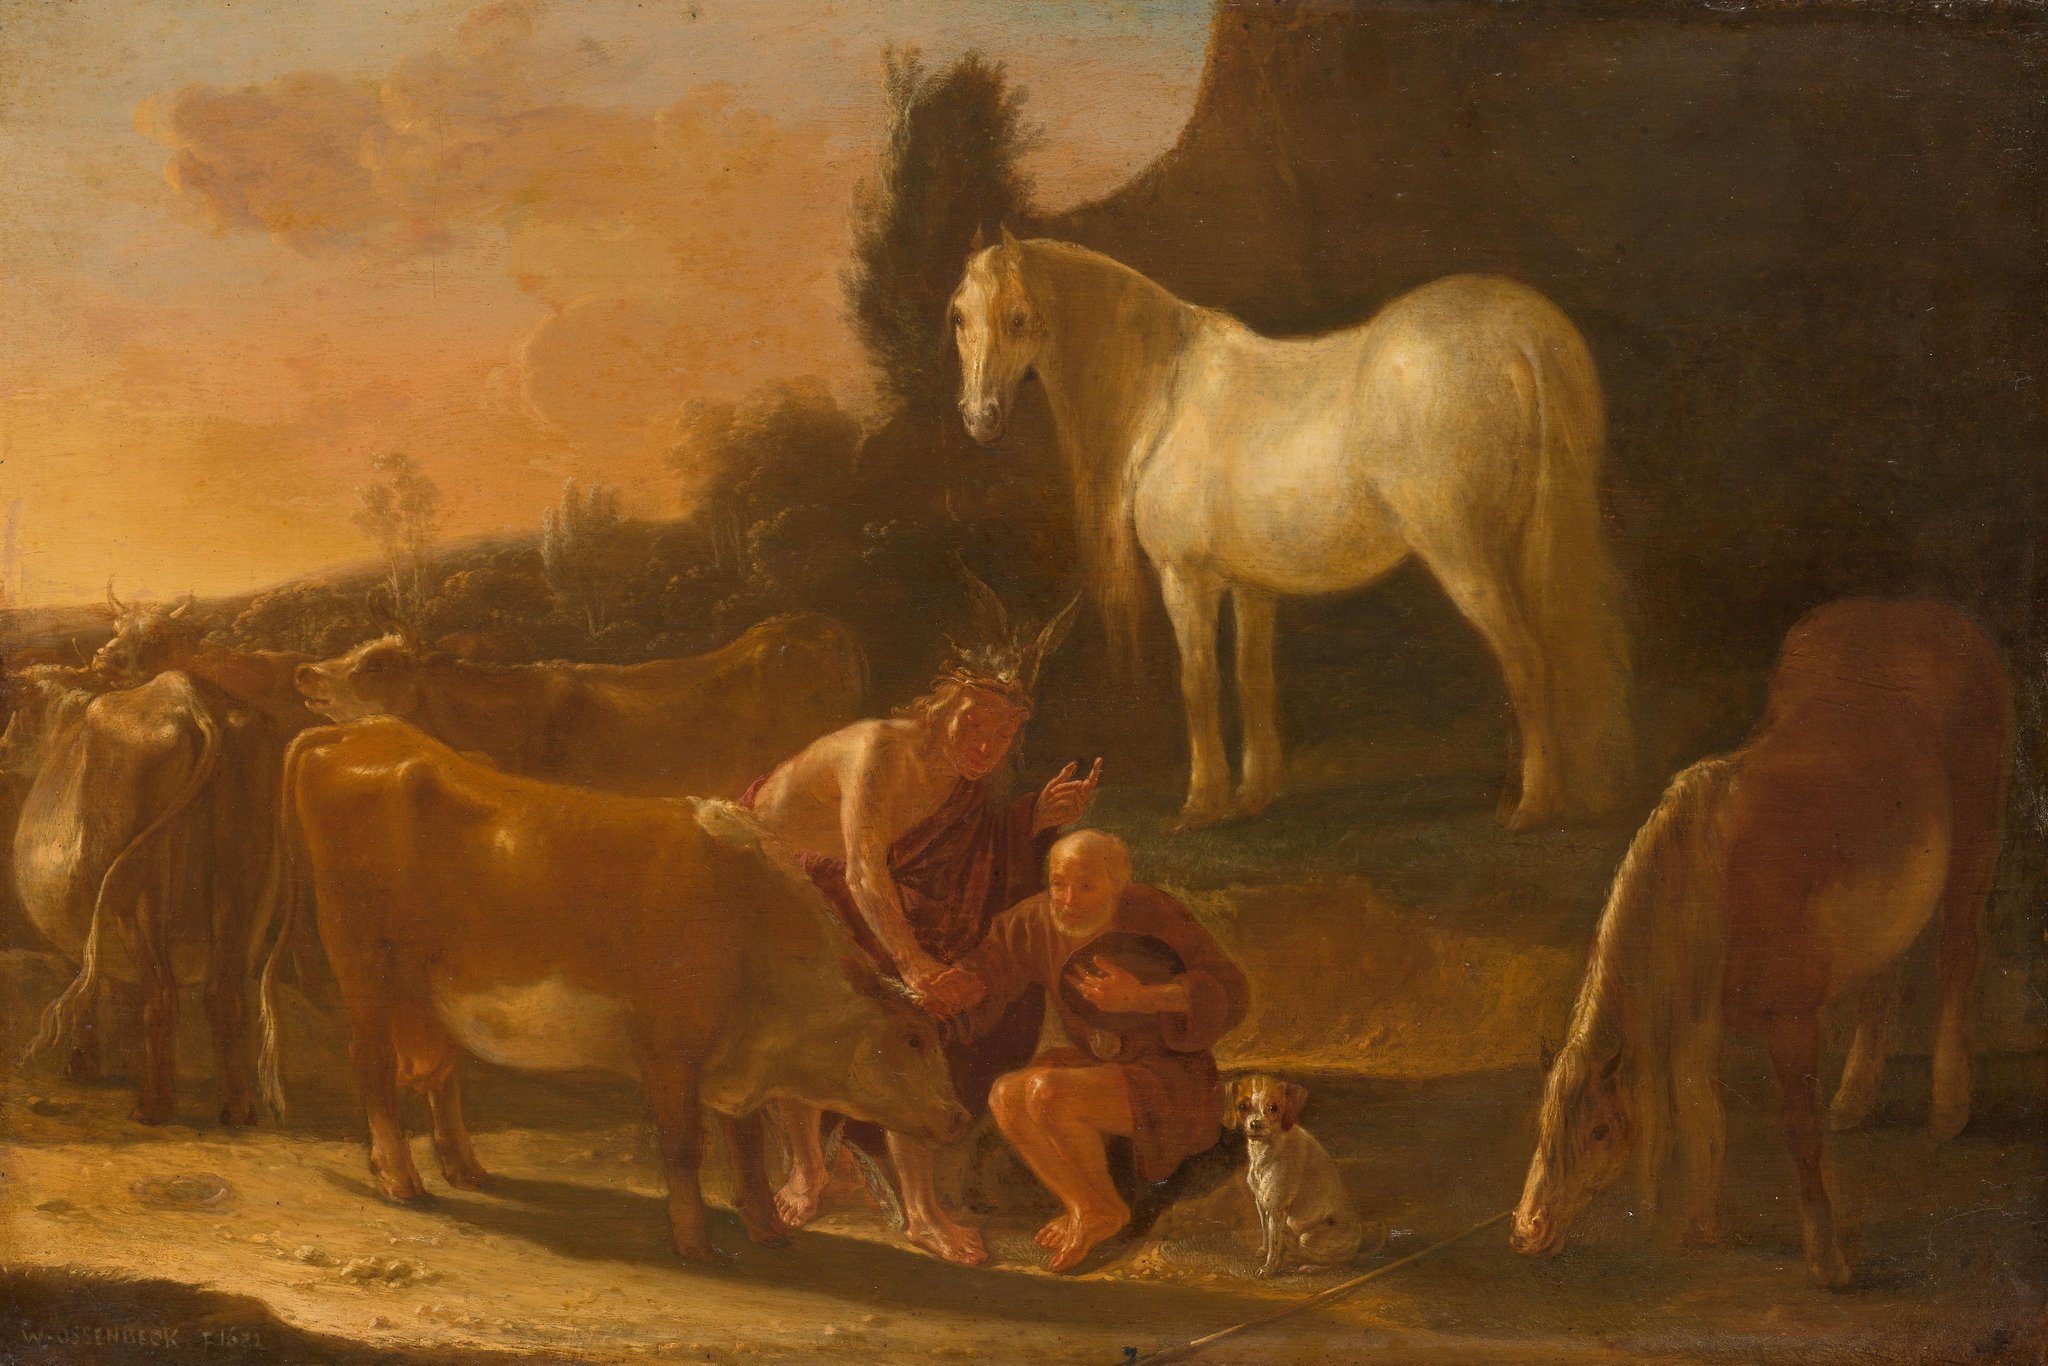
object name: painting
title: Mercury and Io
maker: willem ossenbeeck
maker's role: painter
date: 1632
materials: oil, panel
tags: io is petted by inachus, her father, and by her sisters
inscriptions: signature and date: ‘W. Ossenbeck F. 1632’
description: Mercurius en Io. De door Juno in een koe veranderde Io wordt door Mercurius bij haar vader Inachus teruggebracht. Links een kudde koeien, rechts twee paarden. Bij de voeten van Inachus zit een hondje.